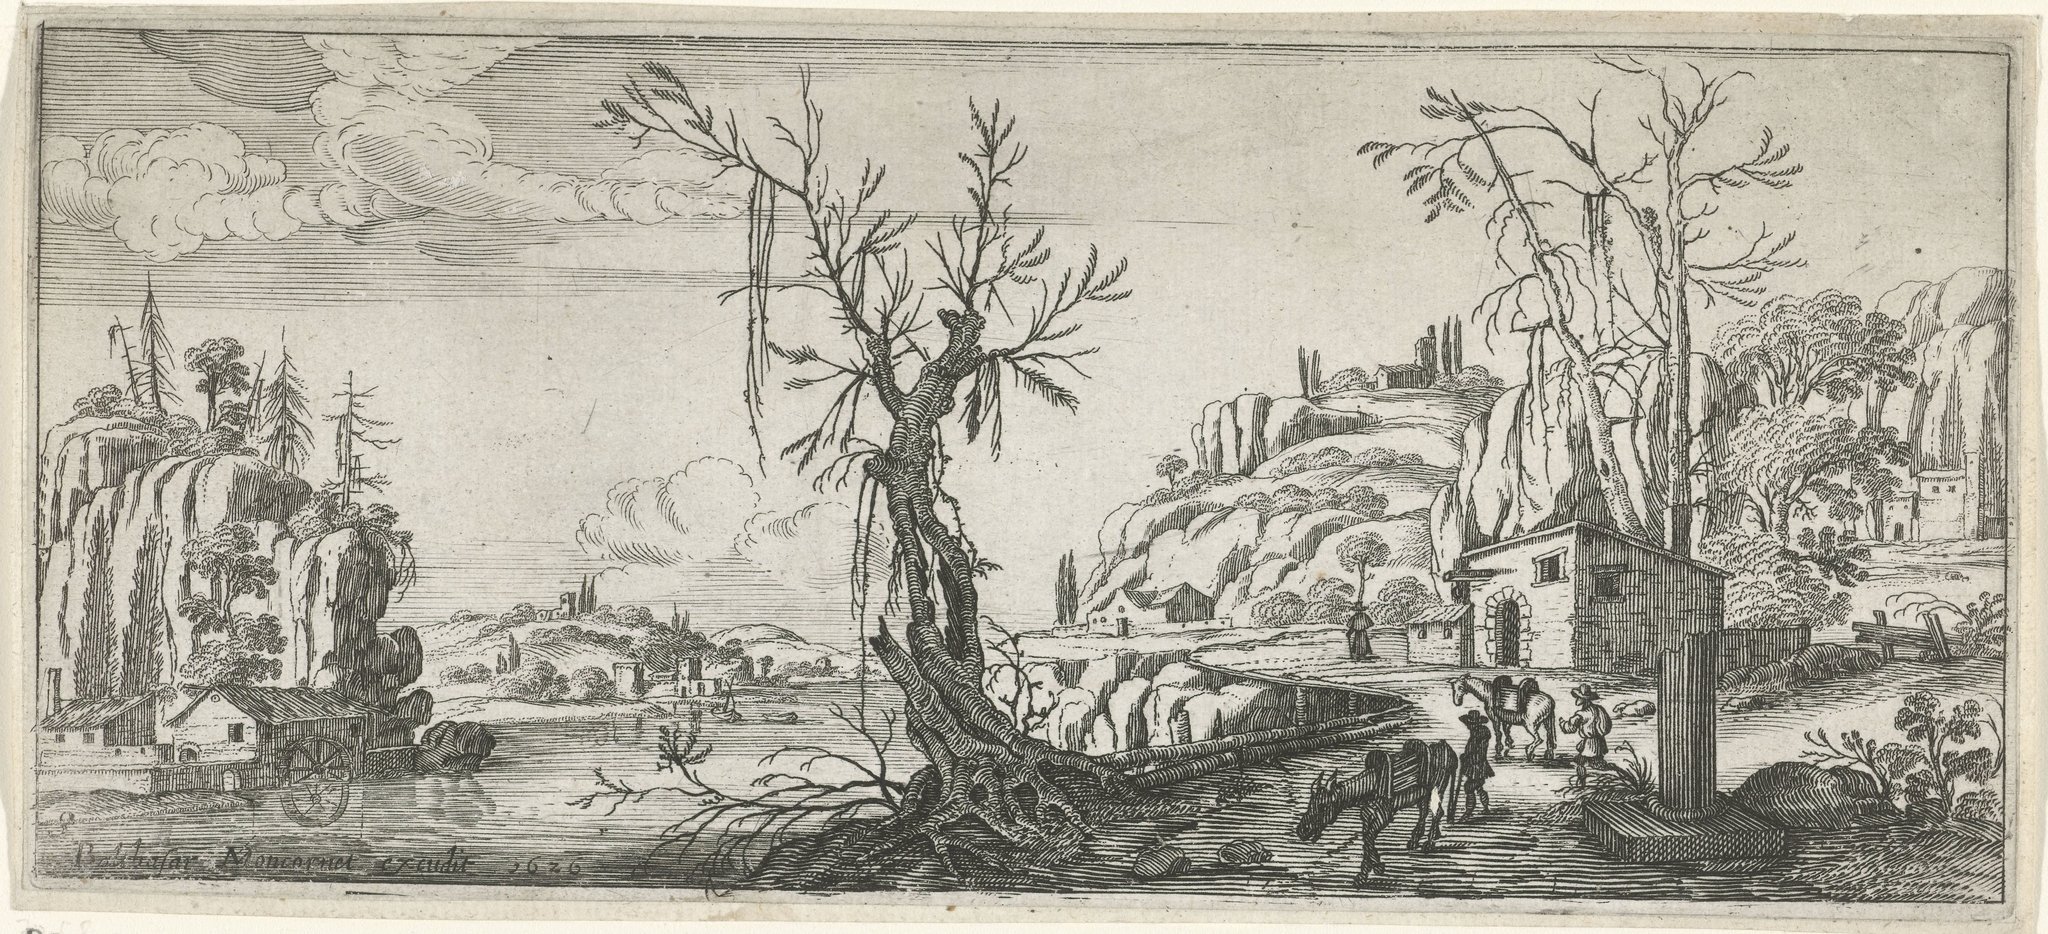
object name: print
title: Landschap met reizigers met pakezels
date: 1626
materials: paper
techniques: engraving, etching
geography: france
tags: pack-animal, watermill in landscape (+ city(-scape) with figures, staffage), landscapes with waters, waterscapes, seascapes (in the temperate zone) (+ landscape with figures, staffage)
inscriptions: collector's mark: Lugt 2228, collector's mark: Lugt 2760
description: Reizigers met pakezels op een landweg , bij een grote dode boom, in een weids rivierlandschap. Links een watermolen.